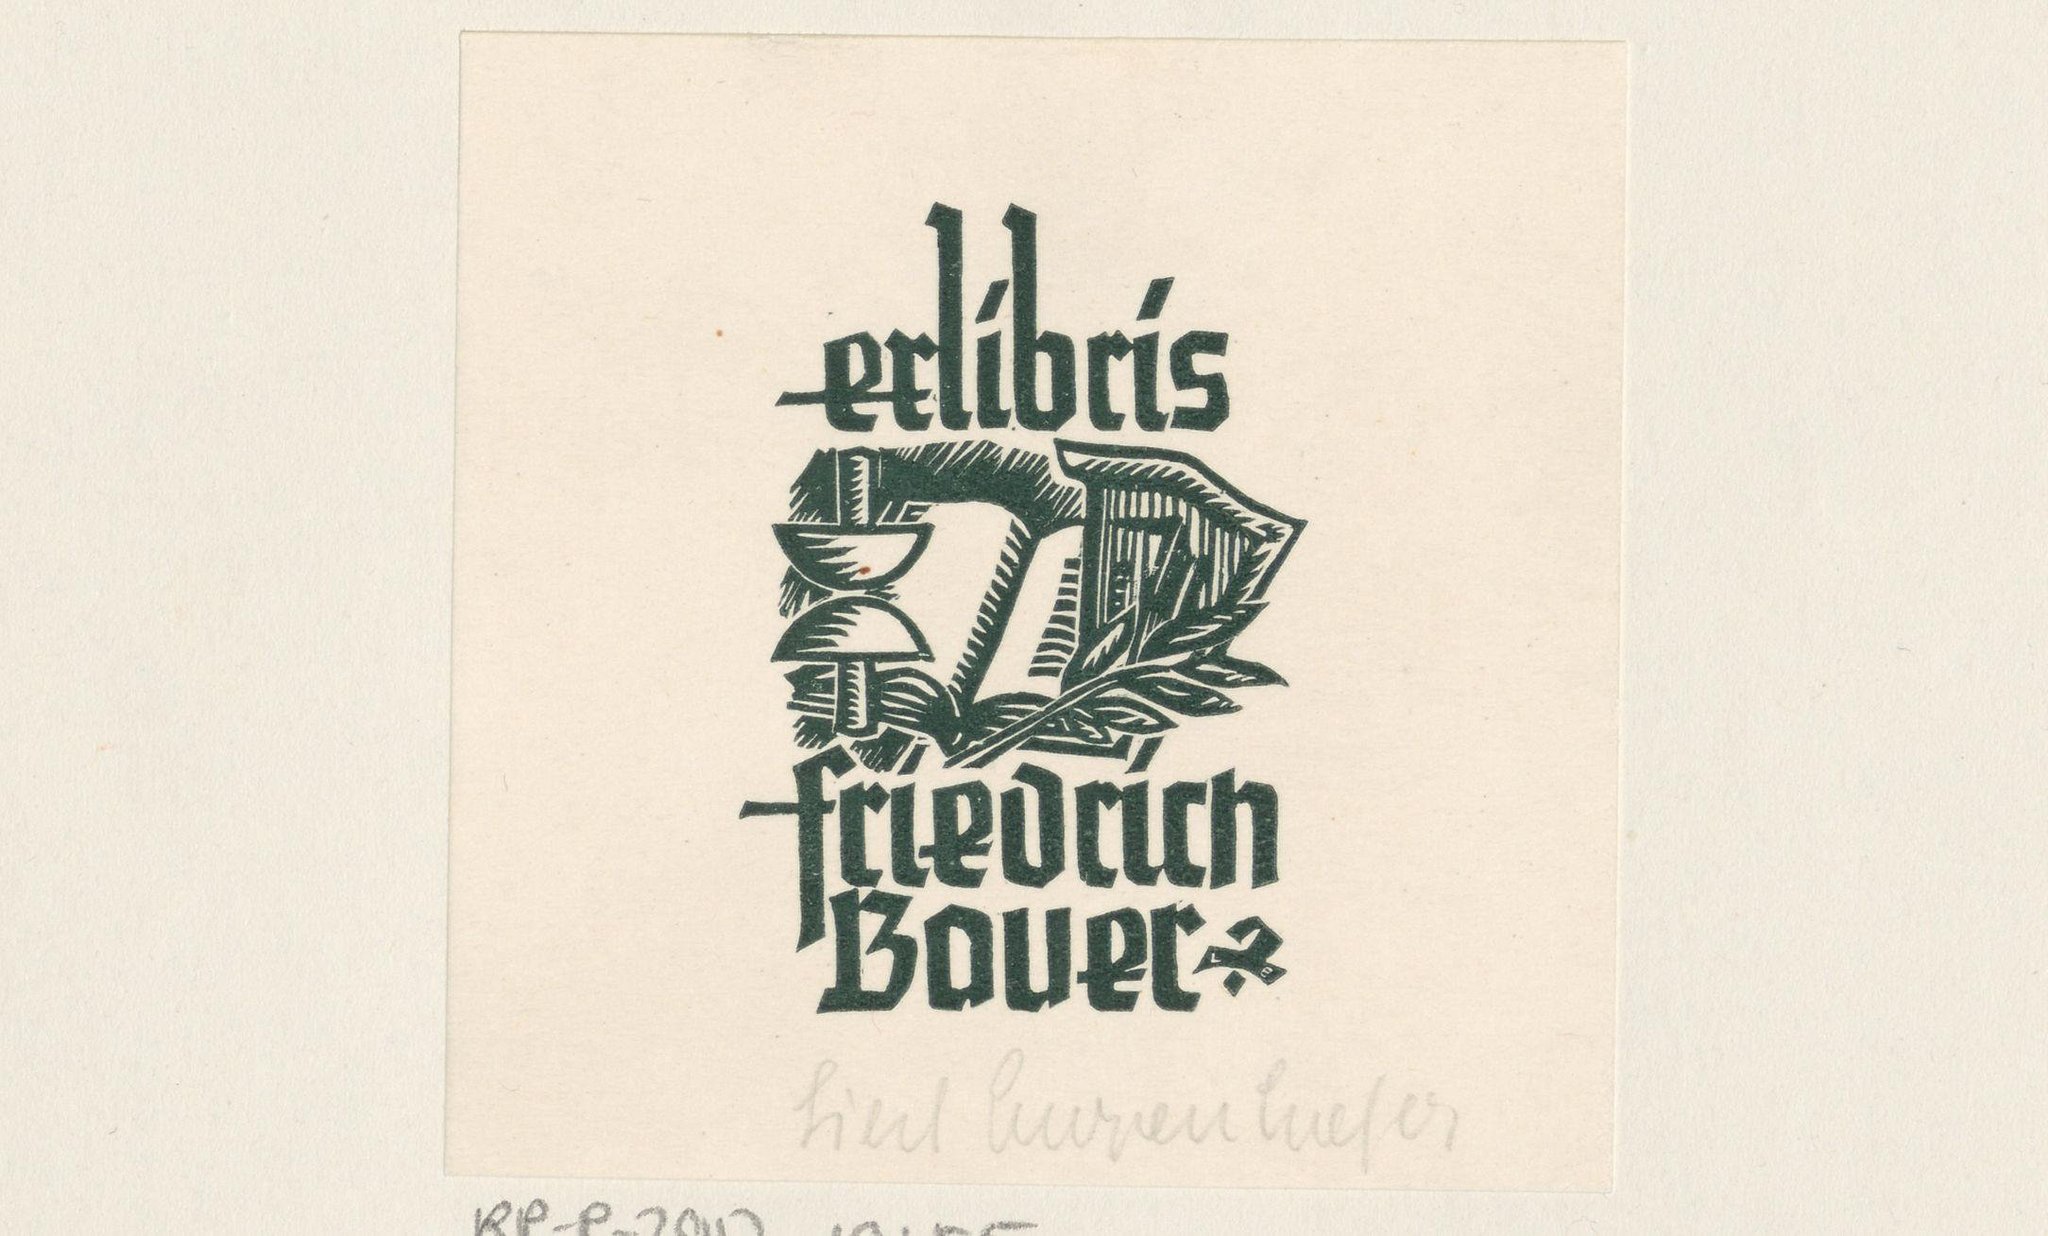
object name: bookplate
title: Ex libris van Friedrich Bauer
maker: Anonymous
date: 1900-1999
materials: paper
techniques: woodcut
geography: germany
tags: friedrich bauer, tools, implements of graphic artist, harp, book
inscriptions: signature: ‘Liesl E[...]hofer’